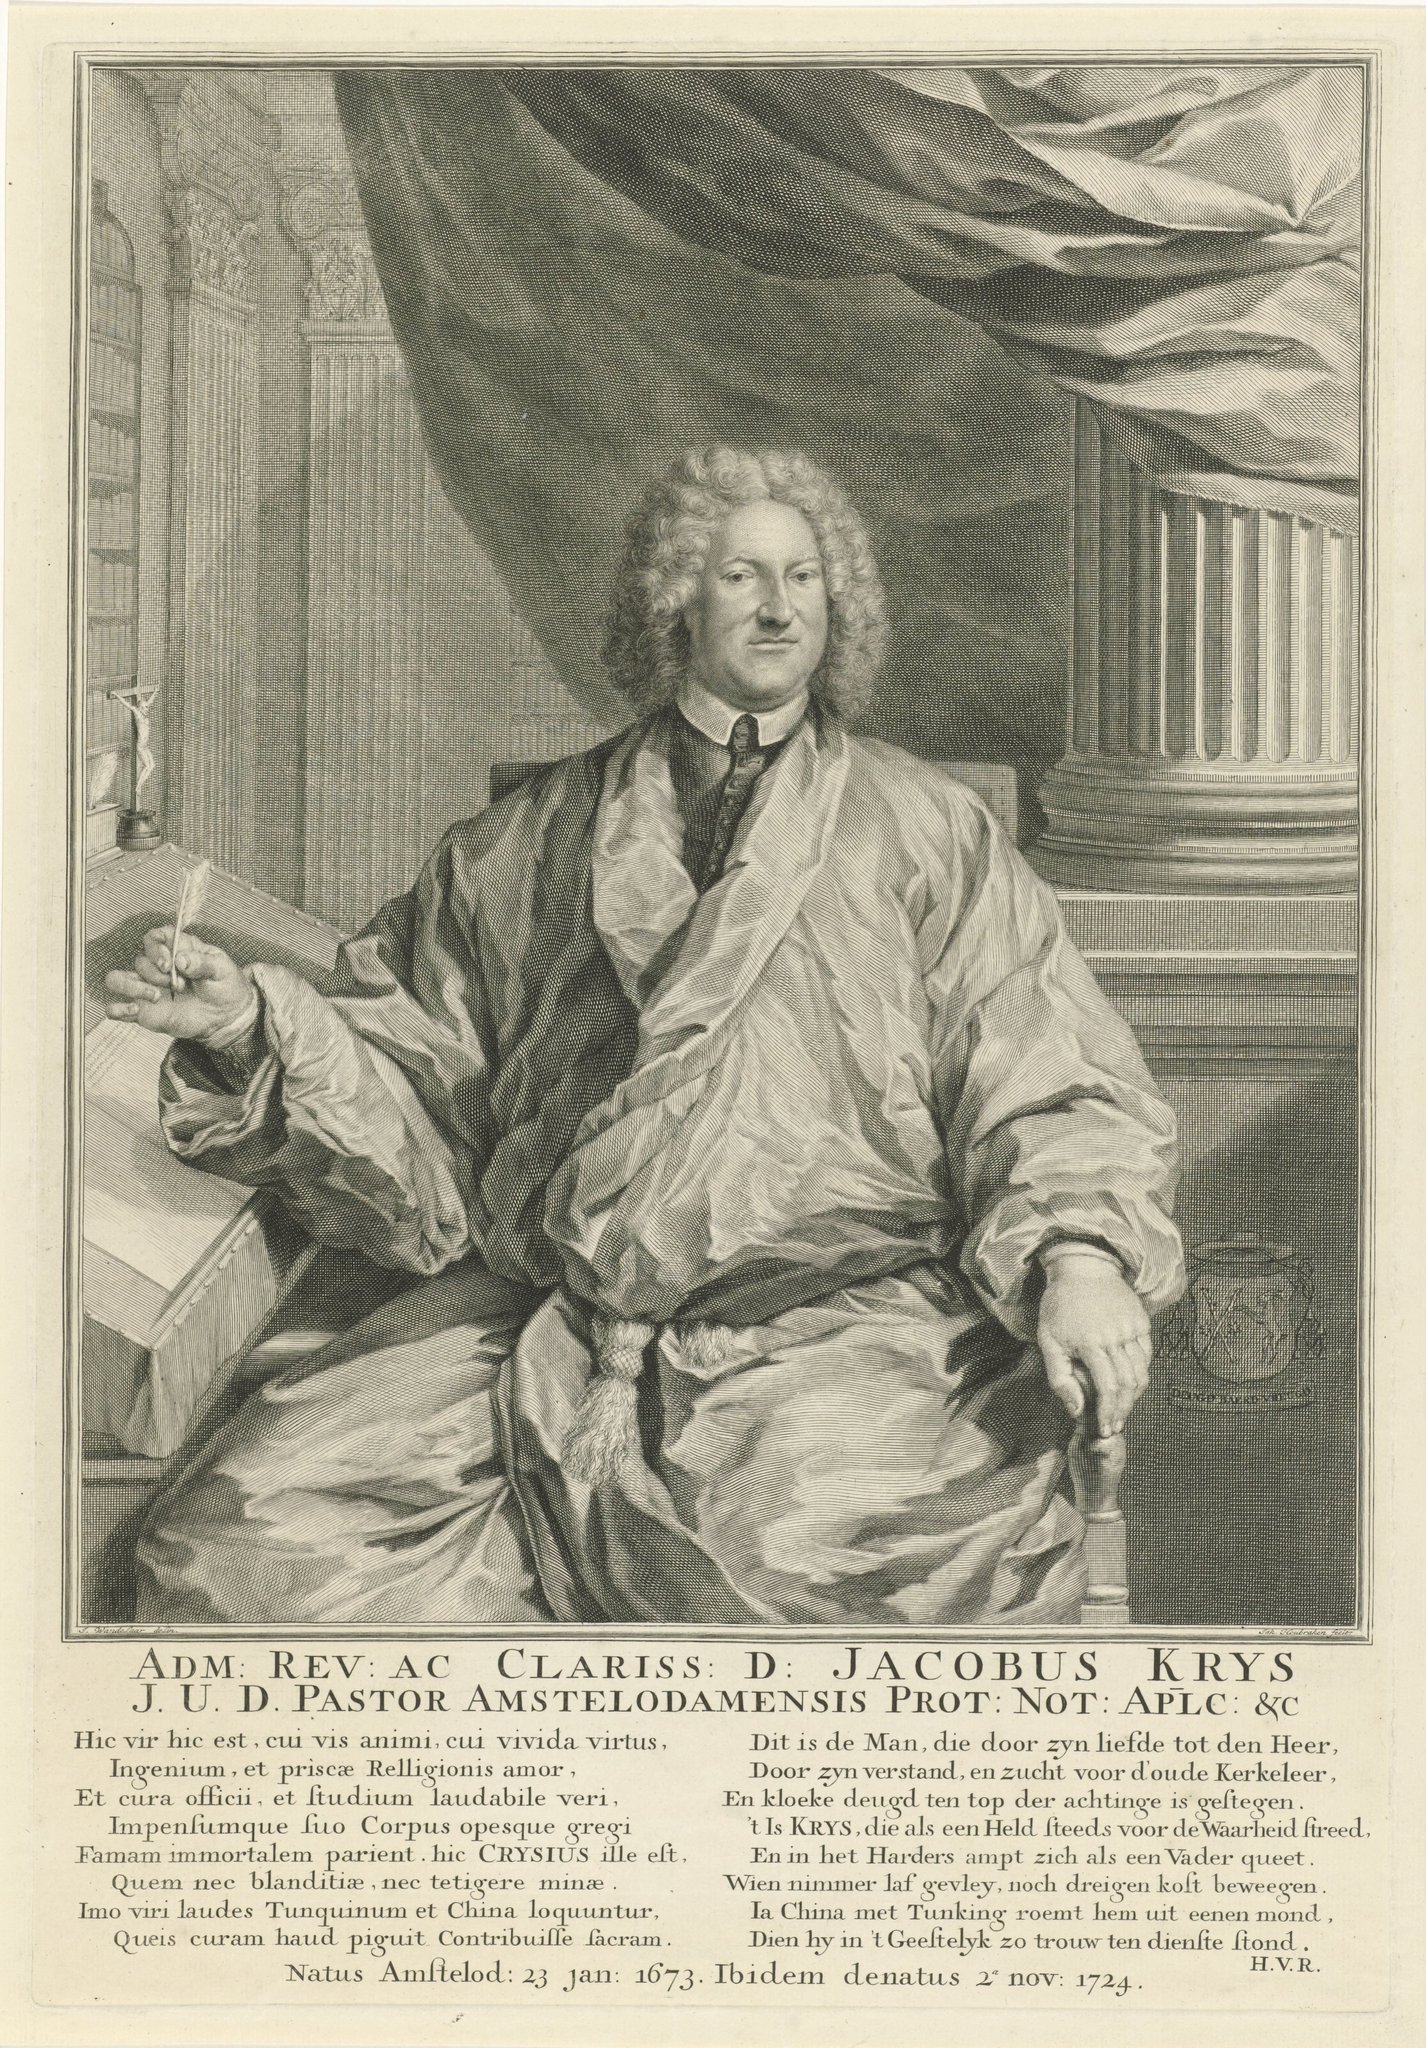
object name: print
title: Jacobus Krys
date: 1724-1780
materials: paper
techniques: engraving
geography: amsterdam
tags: quill, crucifix ~ personal devotion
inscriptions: collector's mark: Lugt 240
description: Jacobus Ignatius Krijs zittend aan een schrijftafel, waarop een crucifix. In zijn hand een schrijfveer. Achter hem een zuil en een gordijn, daarachter twee pilasters en boekenkasten. Rechts van hem een kerkelijk wapen met een devies. Onder het portret zijn naam en gegevens in twee regels in het Latijn. Daaronder twee kolommen van elk acht regels; links in het Latijn en rechts in het Nederlands. Daaronder zijn geboorte- en sterfgegevens in een regel in het Latijn.